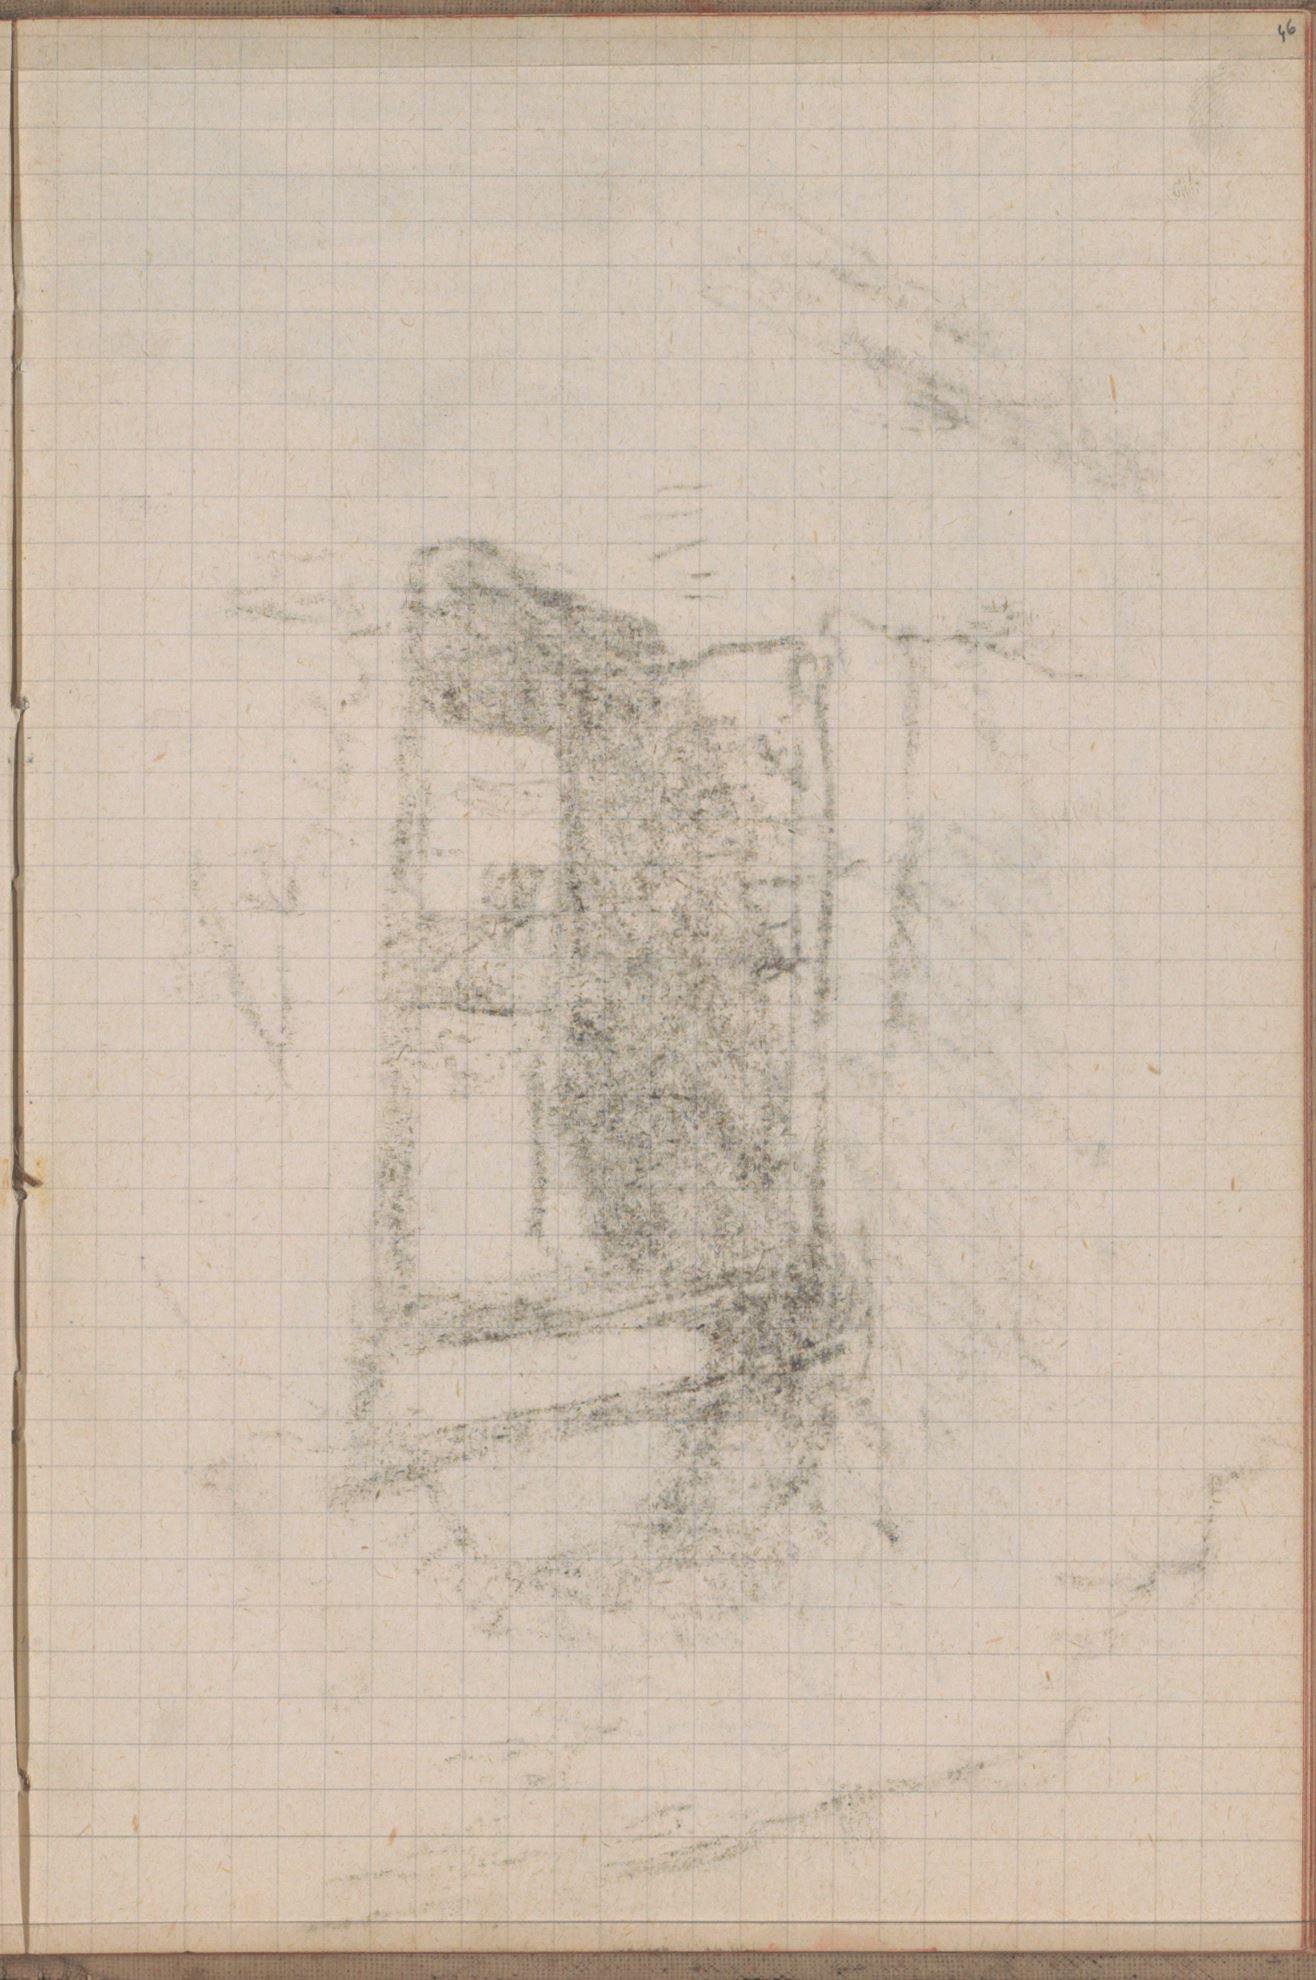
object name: sketchbook leaf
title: Abklatsch van de krijttekening op pagina 45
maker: marius bauer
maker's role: draughtsman, print maker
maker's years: 1867-1932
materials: squared paper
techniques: printmaking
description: Pagina 46 uit een schetsboek met 54 bladen.